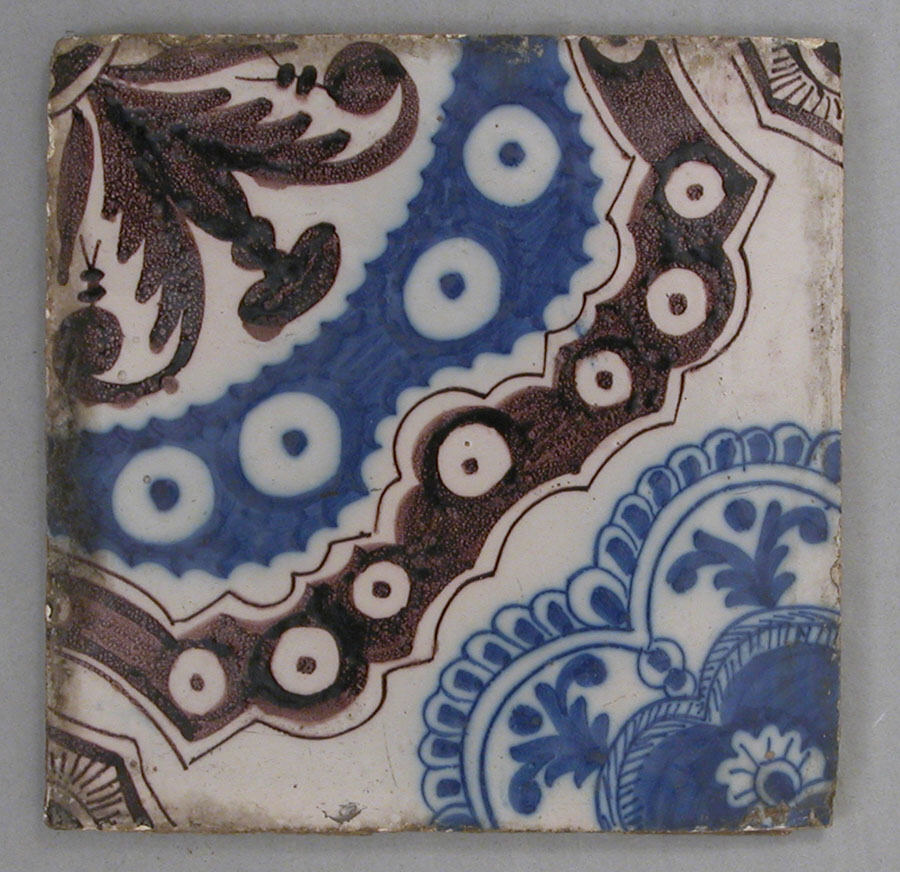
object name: tile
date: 1701-1800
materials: stonepaste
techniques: glazing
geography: north africa